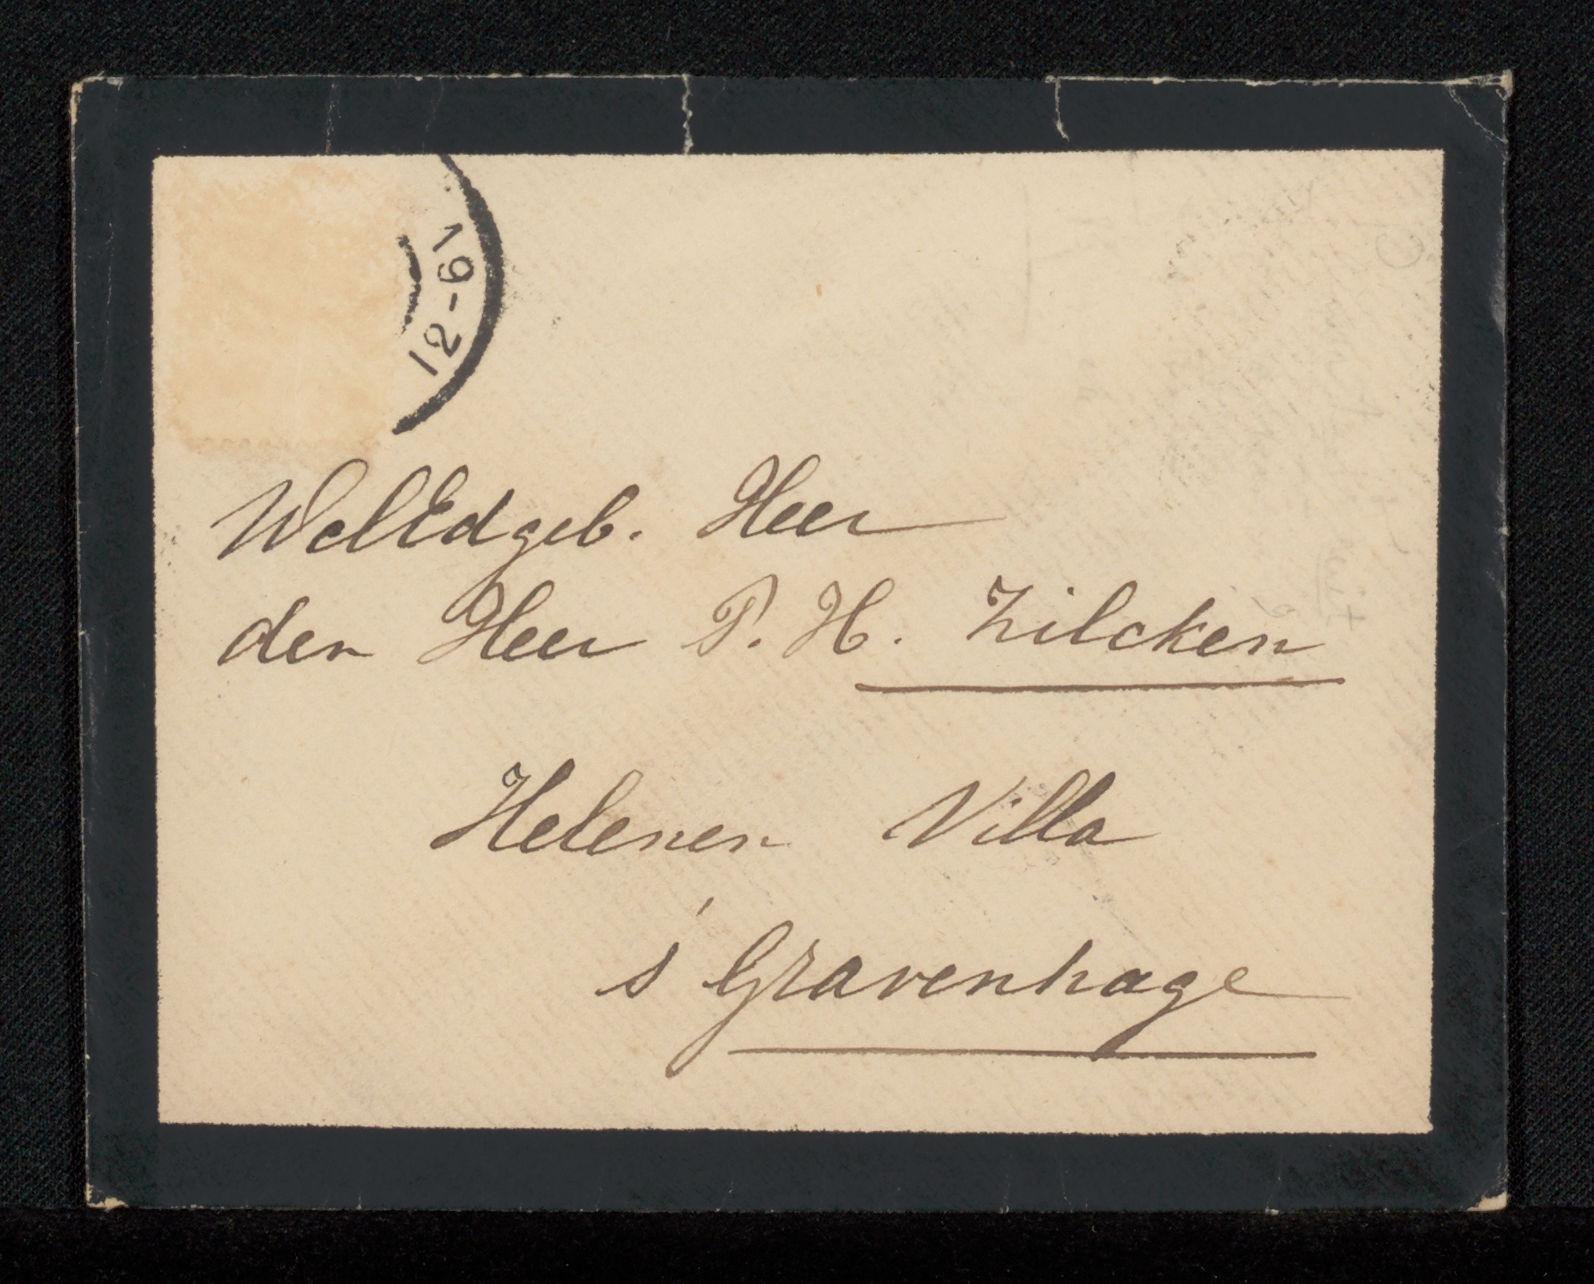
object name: envelope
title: Envelop aan Philip Zilcken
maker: Anonymous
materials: ink, paper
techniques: pen, writing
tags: the hague, painter, draughtsman, philip zilcken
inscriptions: collector's mark: ‘RPK’